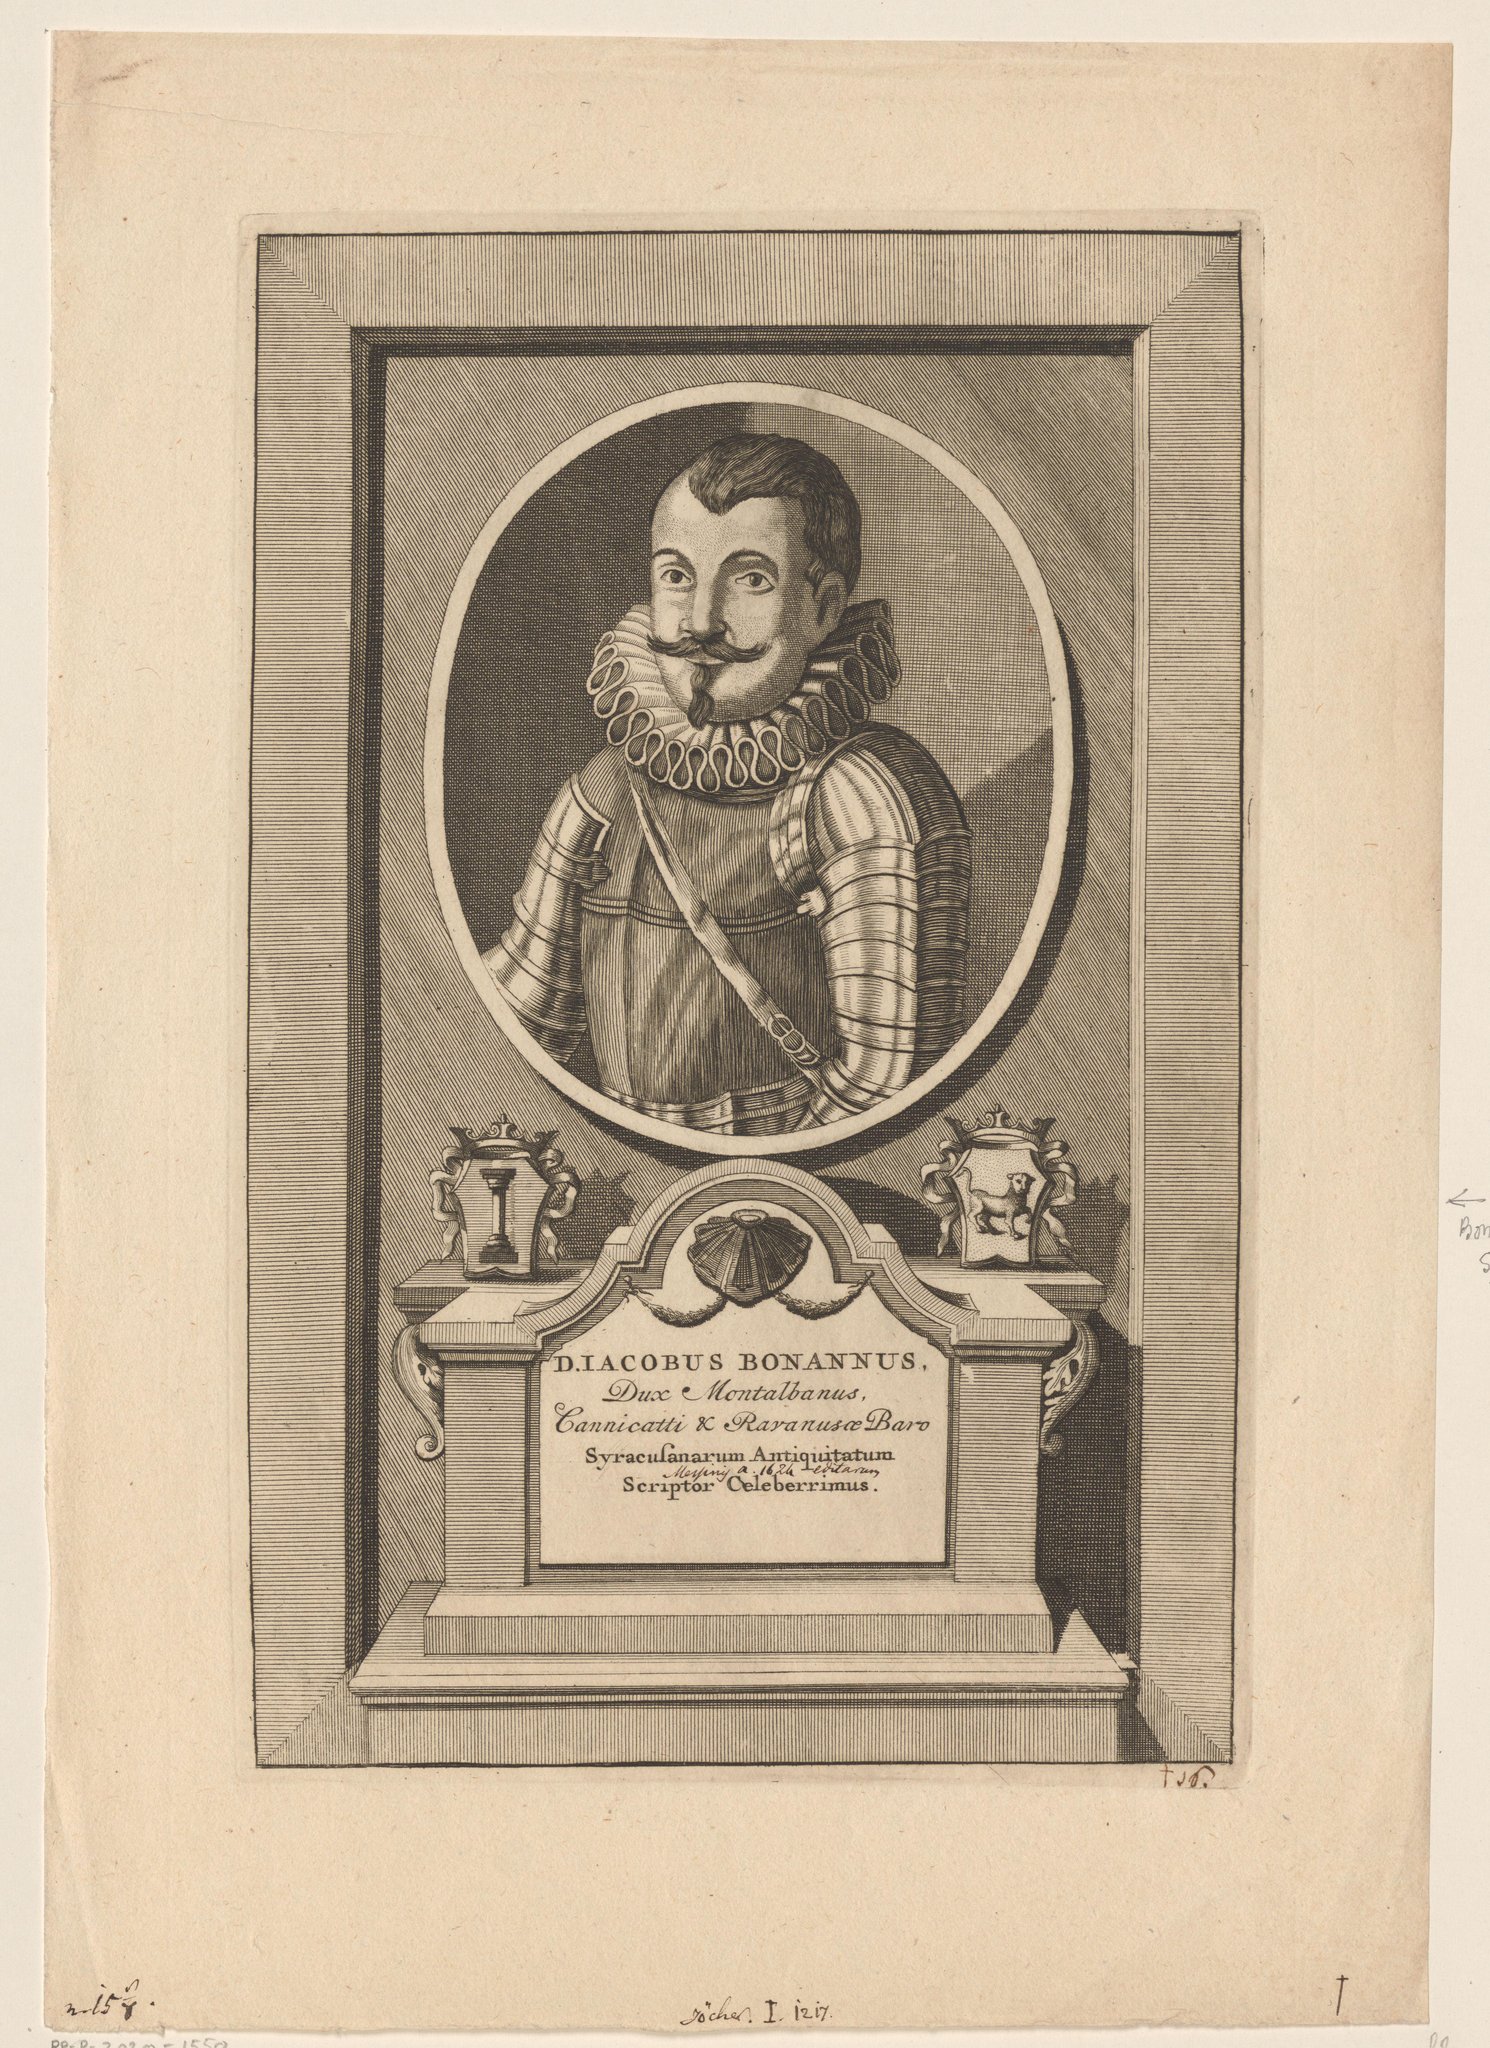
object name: print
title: Portret van Giacomo Bonanni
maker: Anonymous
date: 1700-1730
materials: paper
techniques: engraving, etching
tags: armour, historical persons, armorial bearing, heraldry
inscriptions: inscription: ‘[...]’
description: Prent mogelijk uit: Bonanni, Giacomo. Syracusarum antiquarum illustratarum libri duo. Leiden: Pieter van der Aa, [ca. 1725].